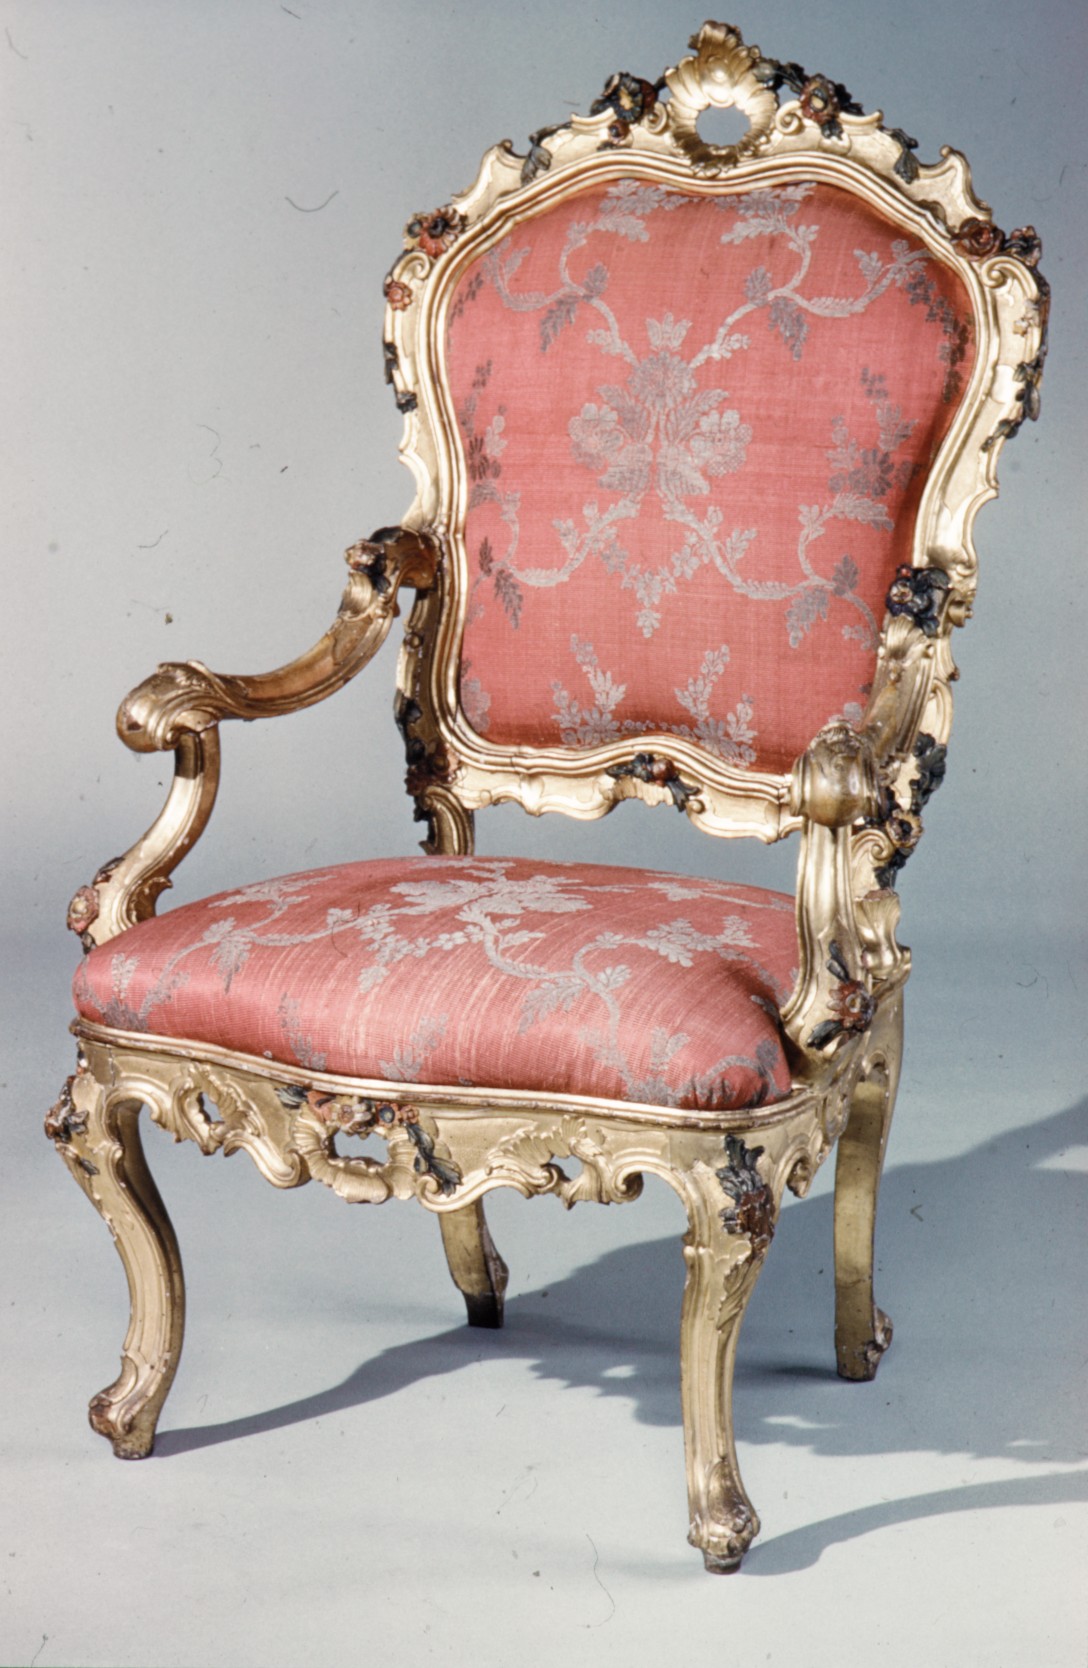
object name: armchair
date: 1734-1766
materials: wood, velvet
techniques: carving, gilding, painting